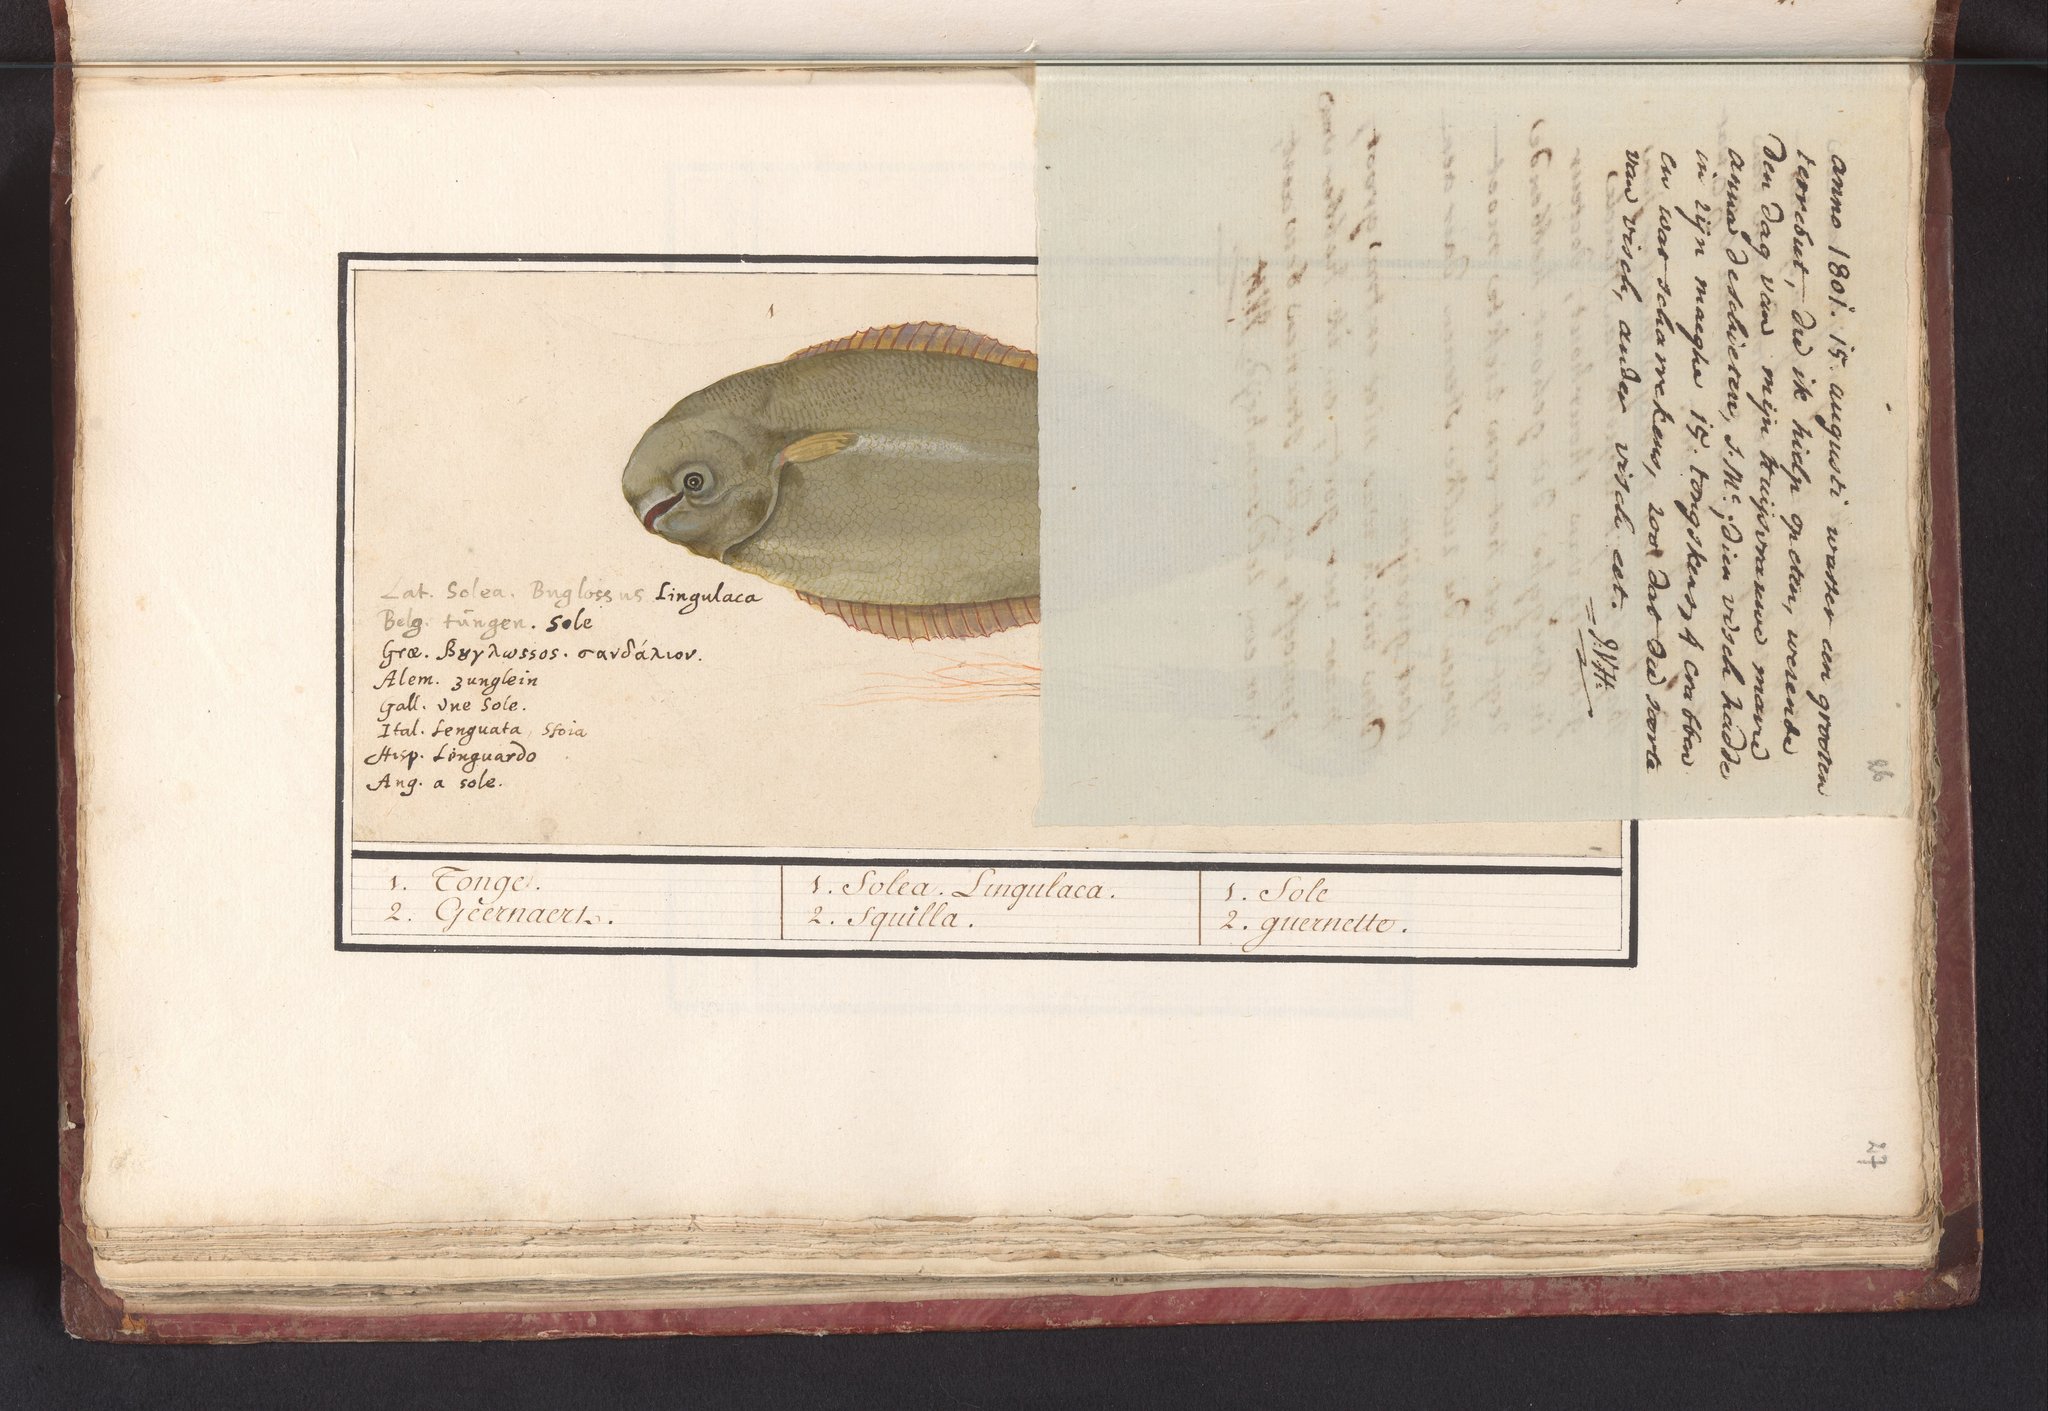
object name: manuscript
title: Briefje van J.A. van Huerne over een tarbot (1801)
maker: joseph van huerne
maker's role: kunstliefhebber, mecenas, verzamelaar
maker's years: 1752-1844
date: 1809-1814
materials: ink, paper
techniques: pen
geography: bruges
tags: boney fishes: turbot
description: Notitie van J.A. van Huerne over een tarbot, 15 augustus 1801. Blad ingebonden in het zesde album met tekeningen van vissen, schelpen en insekten. Zesde van twaalf albums met tekeningen van dieren, vogels en planten bekend rond 1600, gemaakt in opdracht van keizer Rudolf II. Met toelichting in Nederlands, Latijn en Frans.